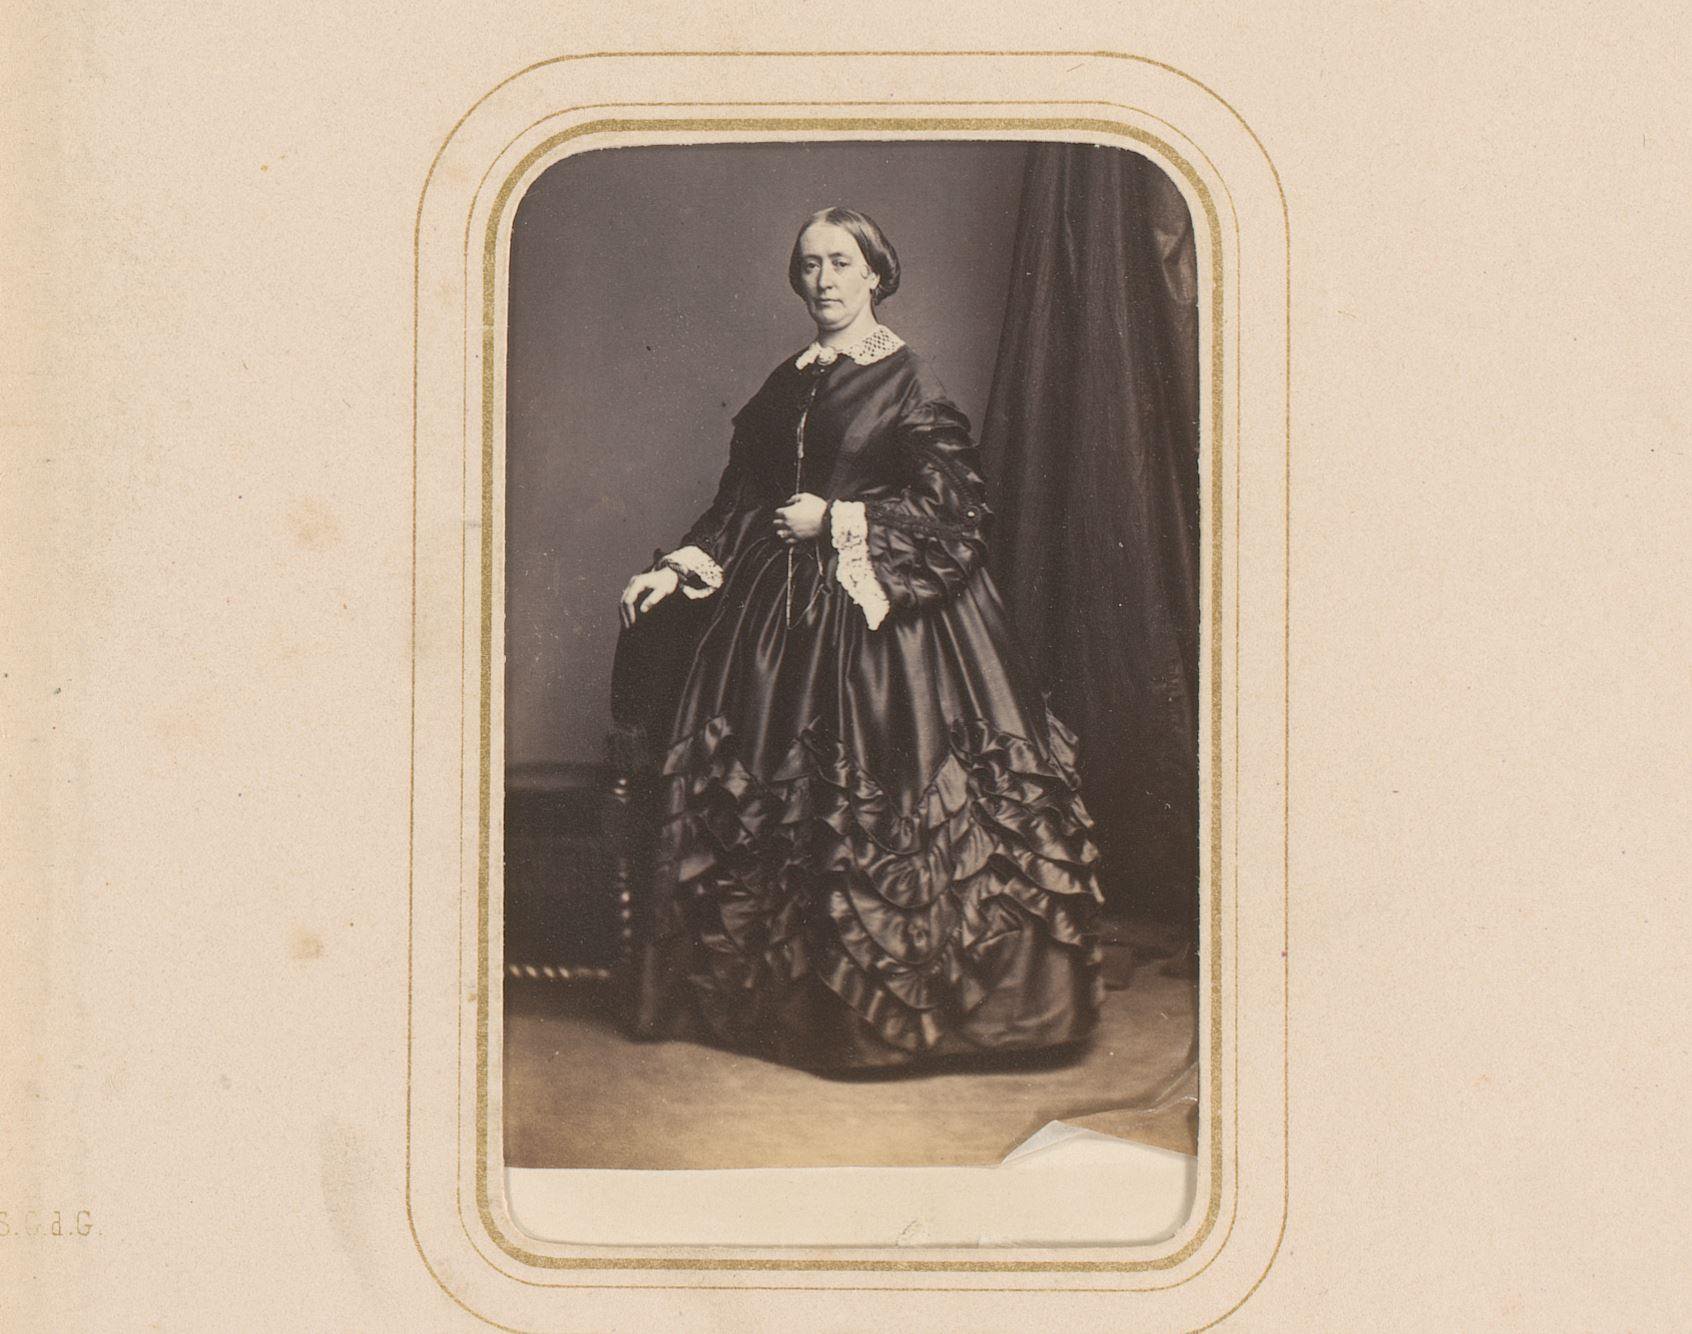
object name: carte de visite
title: Portret van een vrouw, staand bij een stoel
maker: bassano (fotograaf)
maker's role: fotograaf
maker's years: 1829-1913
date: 1860-1900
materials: cardboard, photographic support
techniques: albumen print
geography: london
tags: historical persons - bb - woman, standing figure - aa - female human figure, chair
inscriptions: inscription: ‘Photographed by/ BASSANO,/ 122, REGENT STREET.’